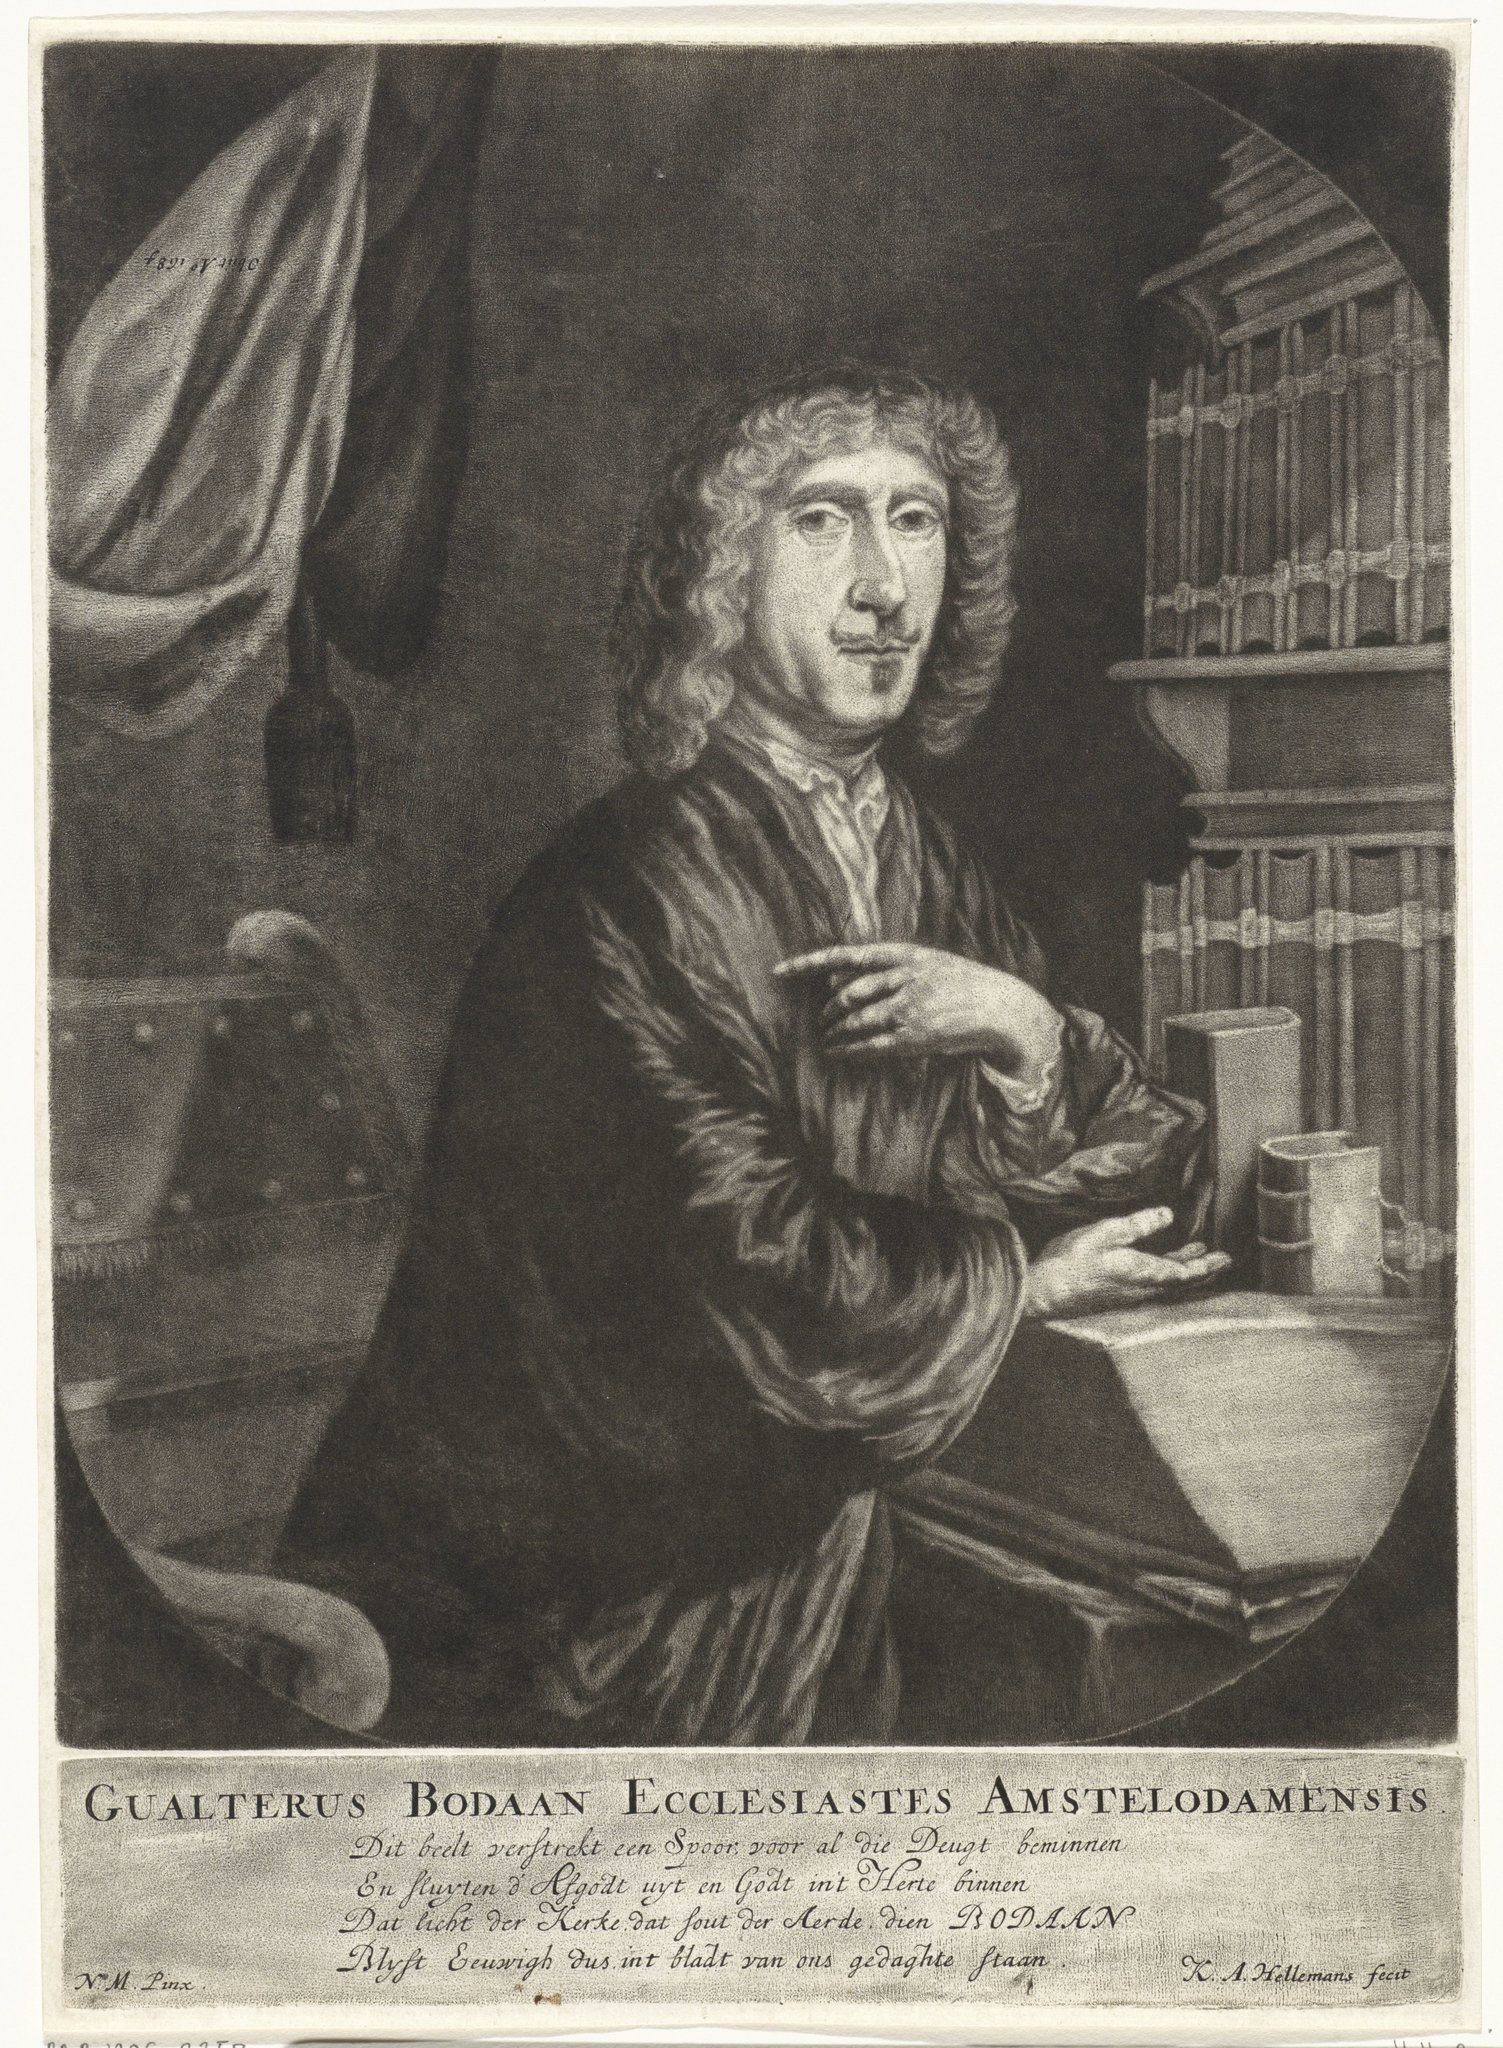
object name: print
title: Portret van Gualterus Bodaan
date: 1684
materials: paper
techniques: engraving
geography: northern netherlands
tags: amsterdam, book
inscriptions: collector's mark: Lugt 2228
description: De theoloog Gualterus Bodaan zit voor zijn boekenkast aan een bureau. Hij laat zijn rechterhand op de bijbel rusten.